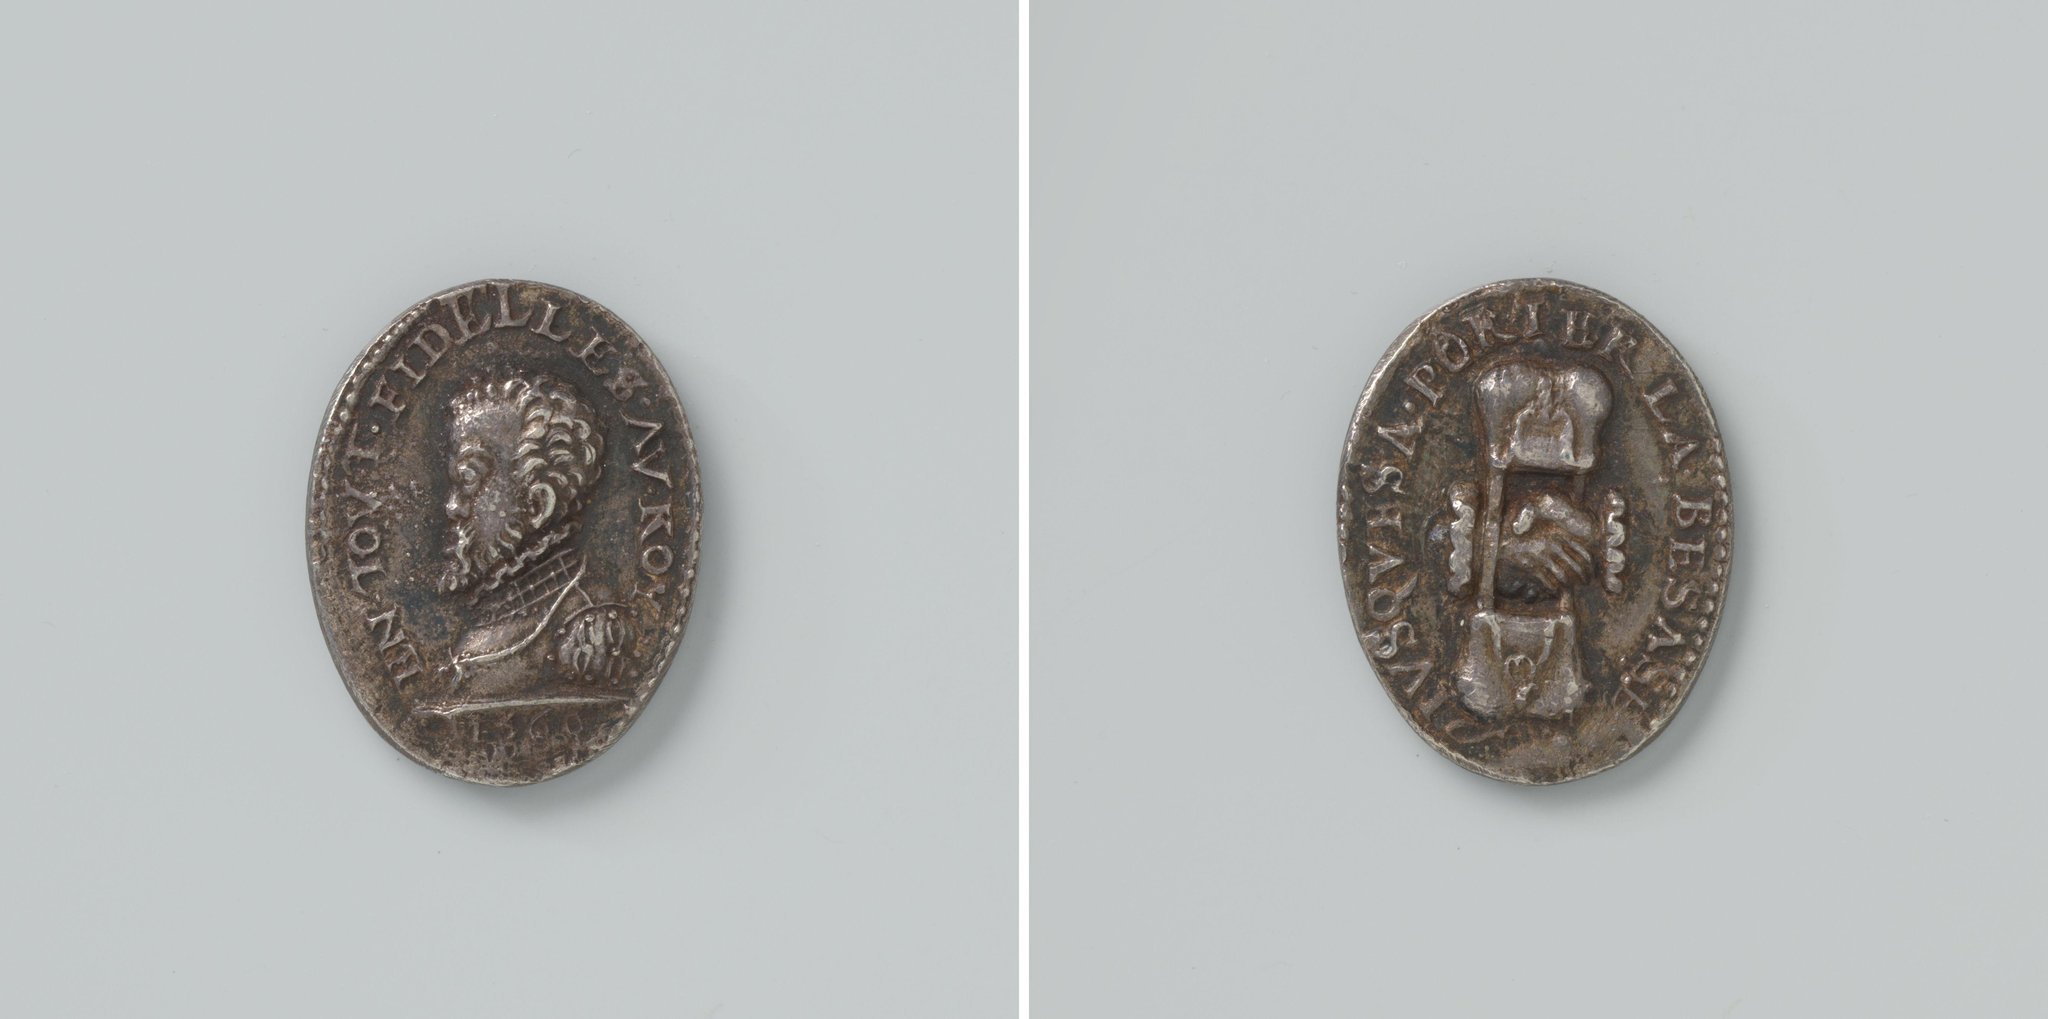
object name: beggar's medal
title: Geuzenpenning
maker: Anonymous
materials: silver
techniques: casting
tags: philip ii of spain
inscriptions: circumscription: ‘IVSQVES A.PORTER.LA.BESACE’, exergue: ‘1566’, circumscription: ‘EN.TOVT.FIDELLES.AV.ROY’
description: Type Jonghelinck, zichtpenning, zonder draagoog [opmerking schenker]